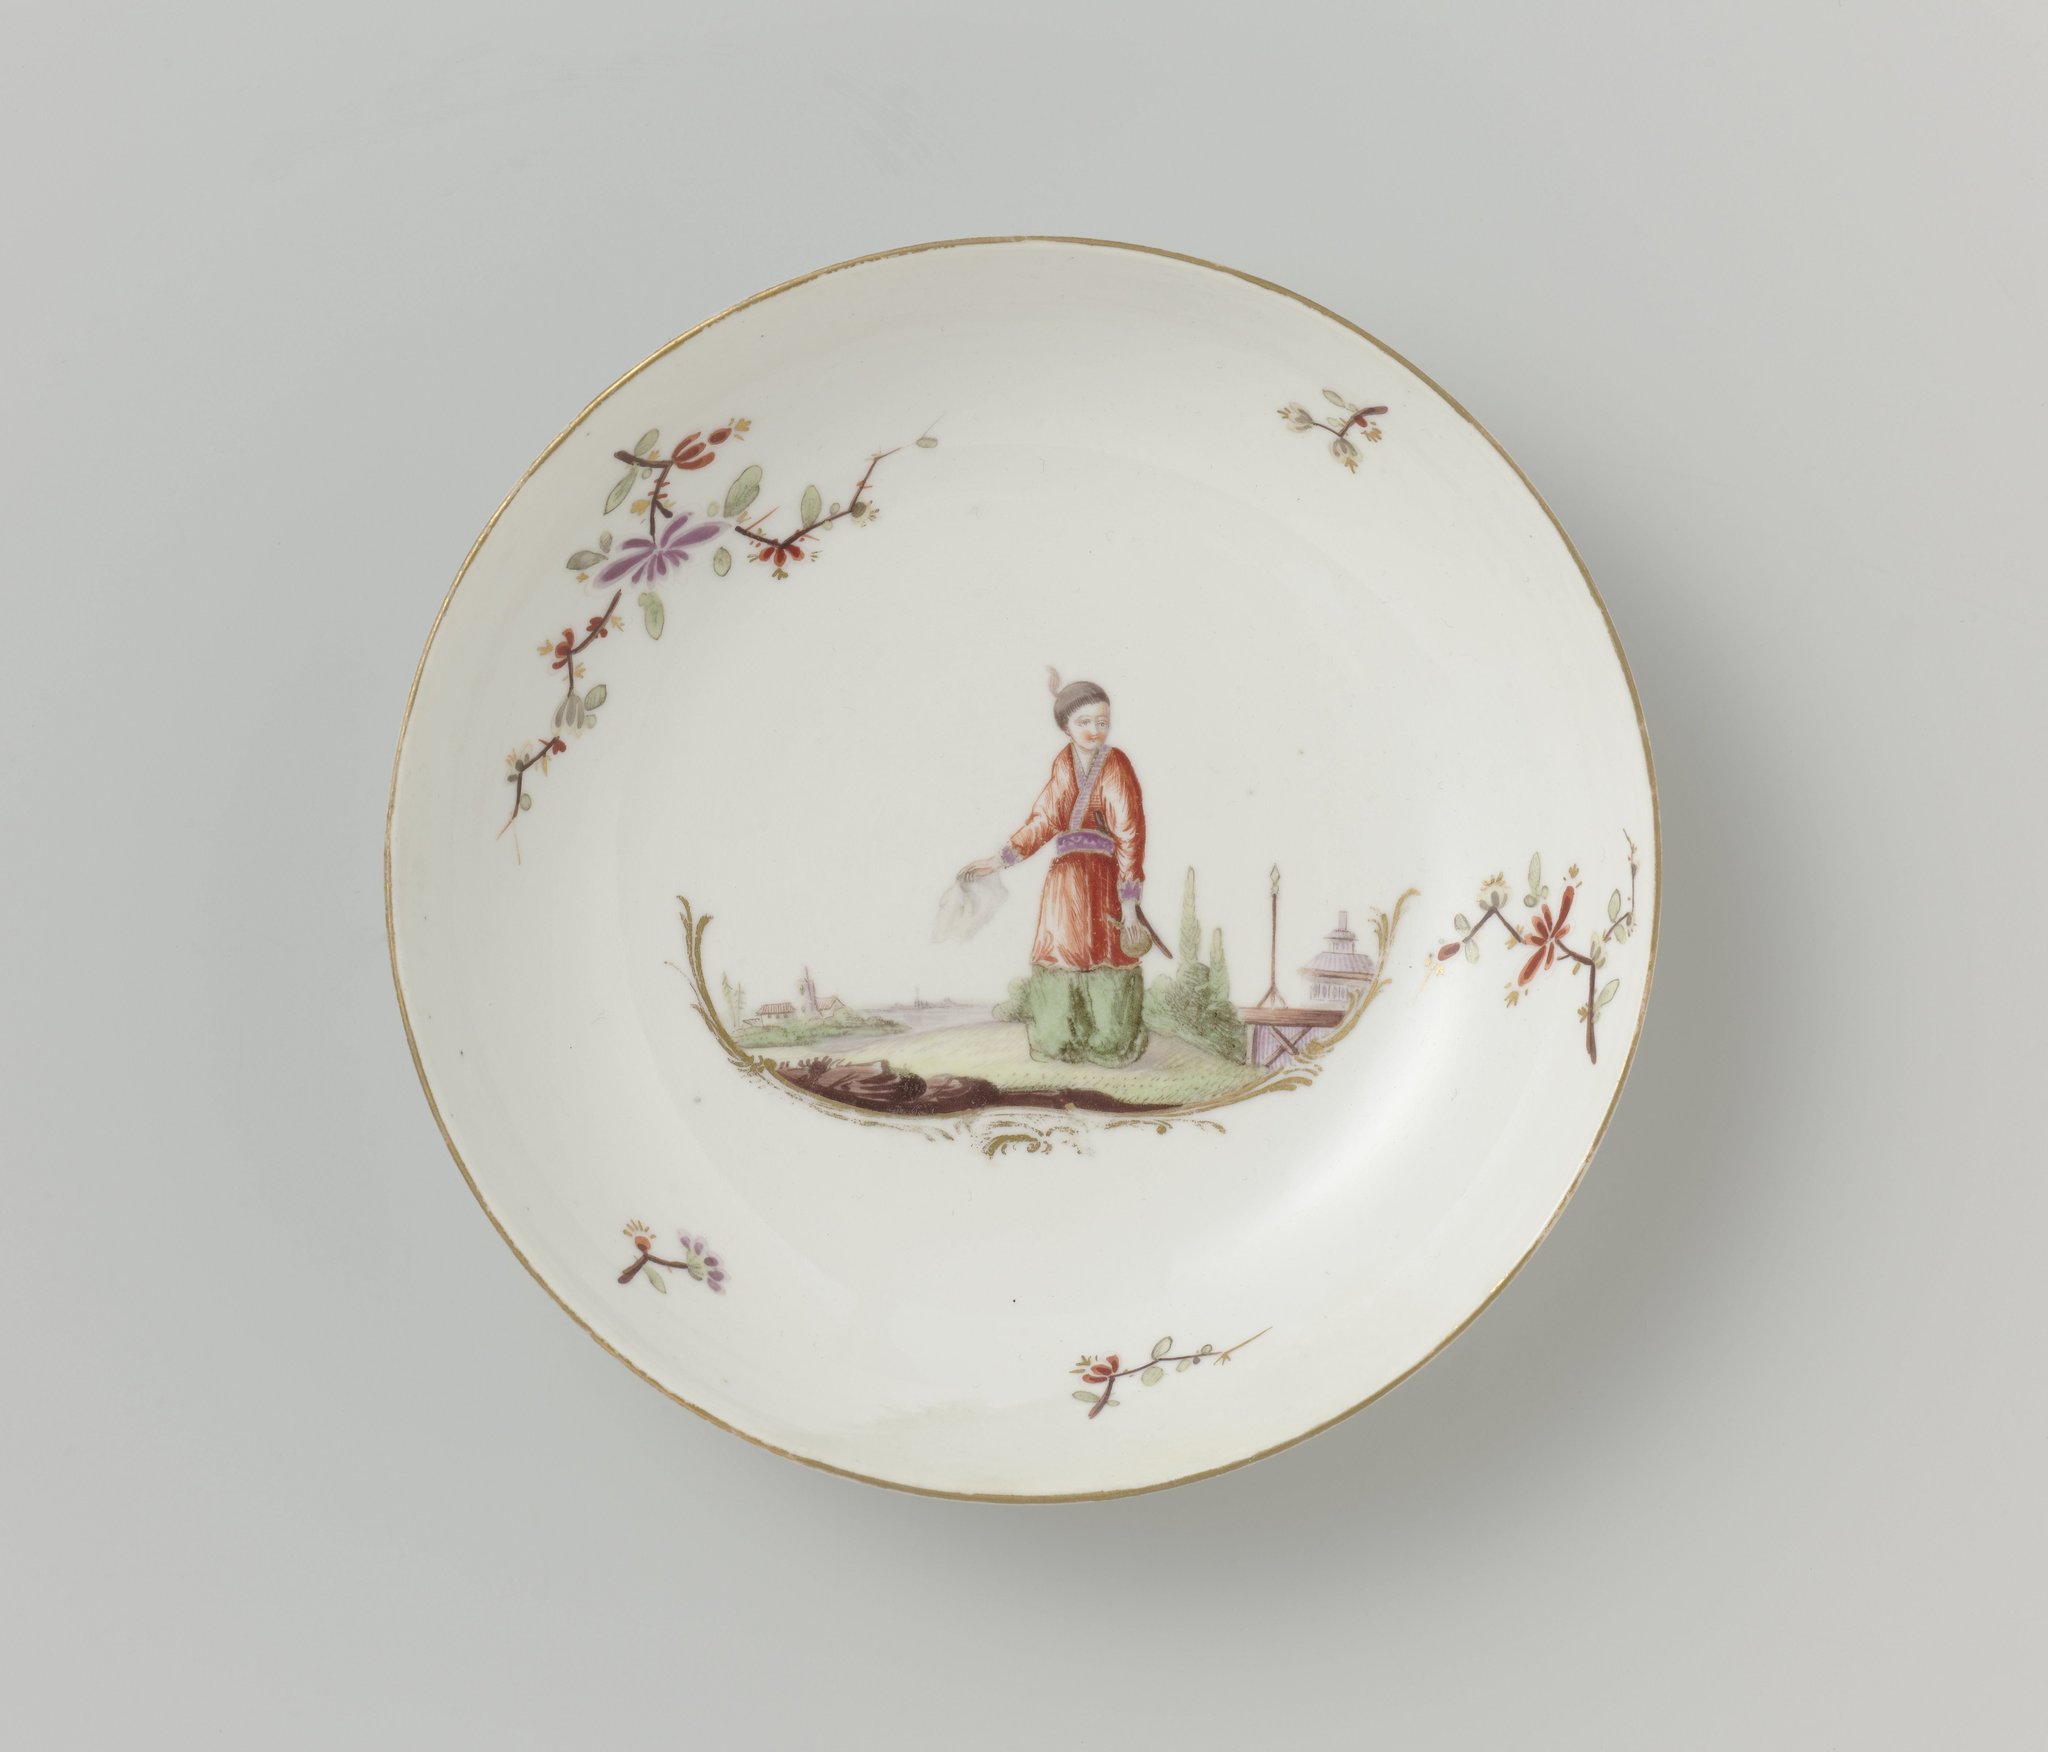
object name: platter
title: Schotel, veelkleurig beschilderd met chinoiserieën en losse bloemtakken langs de randen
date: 1765-1770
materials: porcelain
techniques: painted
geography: weesp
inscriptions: mark: ‘wapen weesp’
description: Schotel, veelkleurig beschilderd met chinoiserieën en losse bloemtakjes langs de randen. Gemerkt met twee gekruiste zwaarden en drie bollen in onderglazuurblauw.